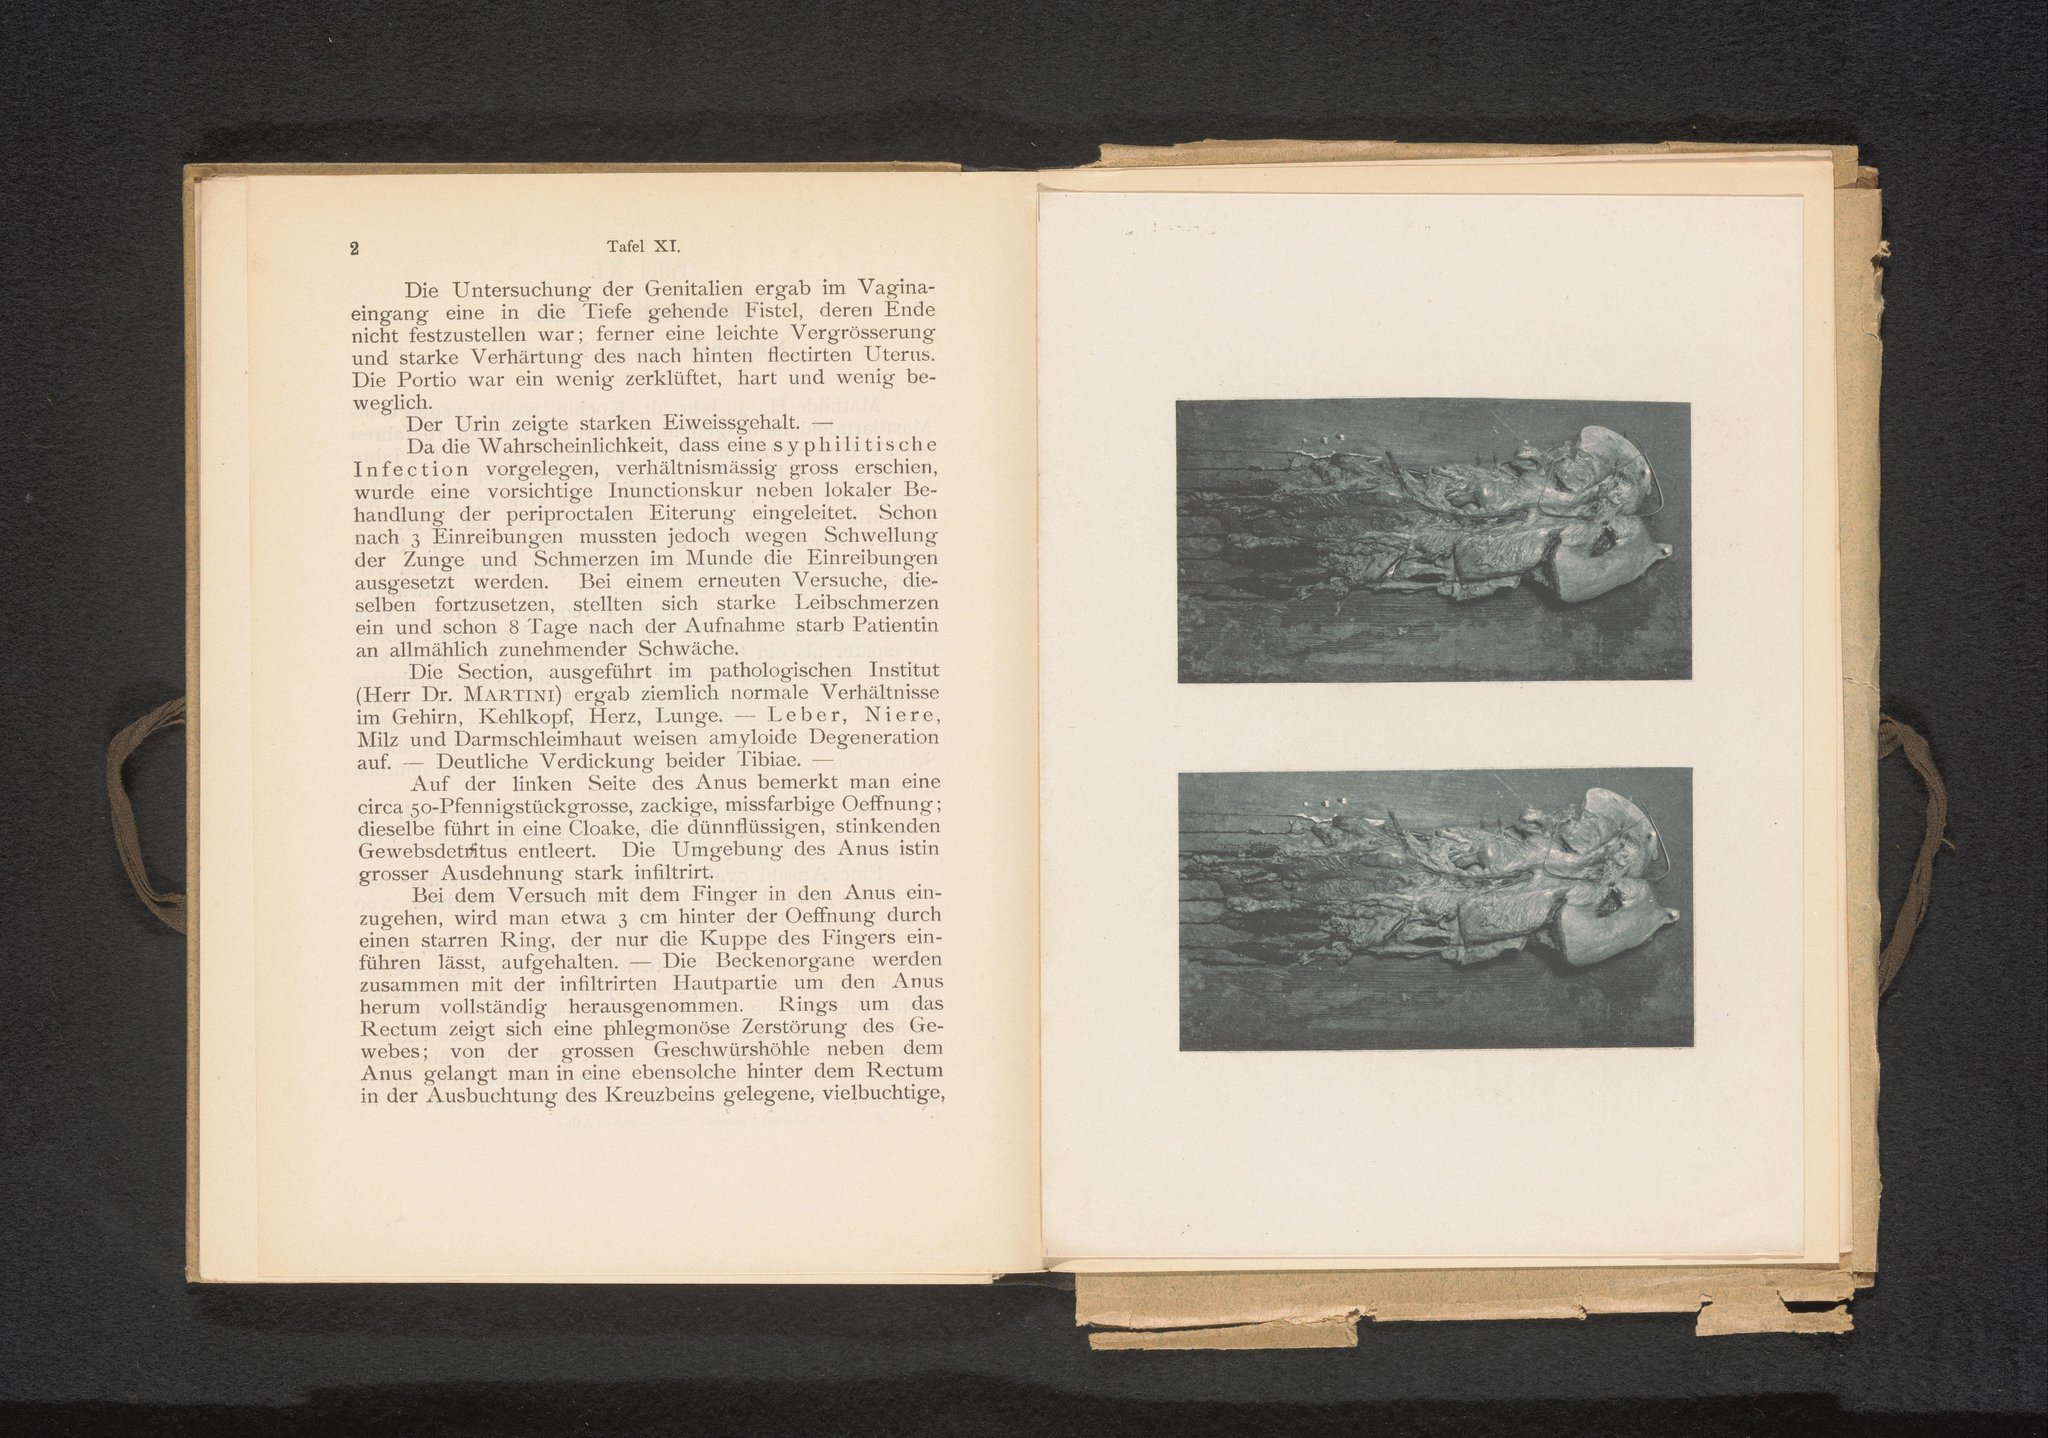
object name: photomechanical print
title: Twee aanblikken van een dikke darm met zweren als gevolg van syfilis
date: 1884-1894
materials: paper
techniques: photoaquatint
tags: intestines, skin and venereal diseases: syphilis